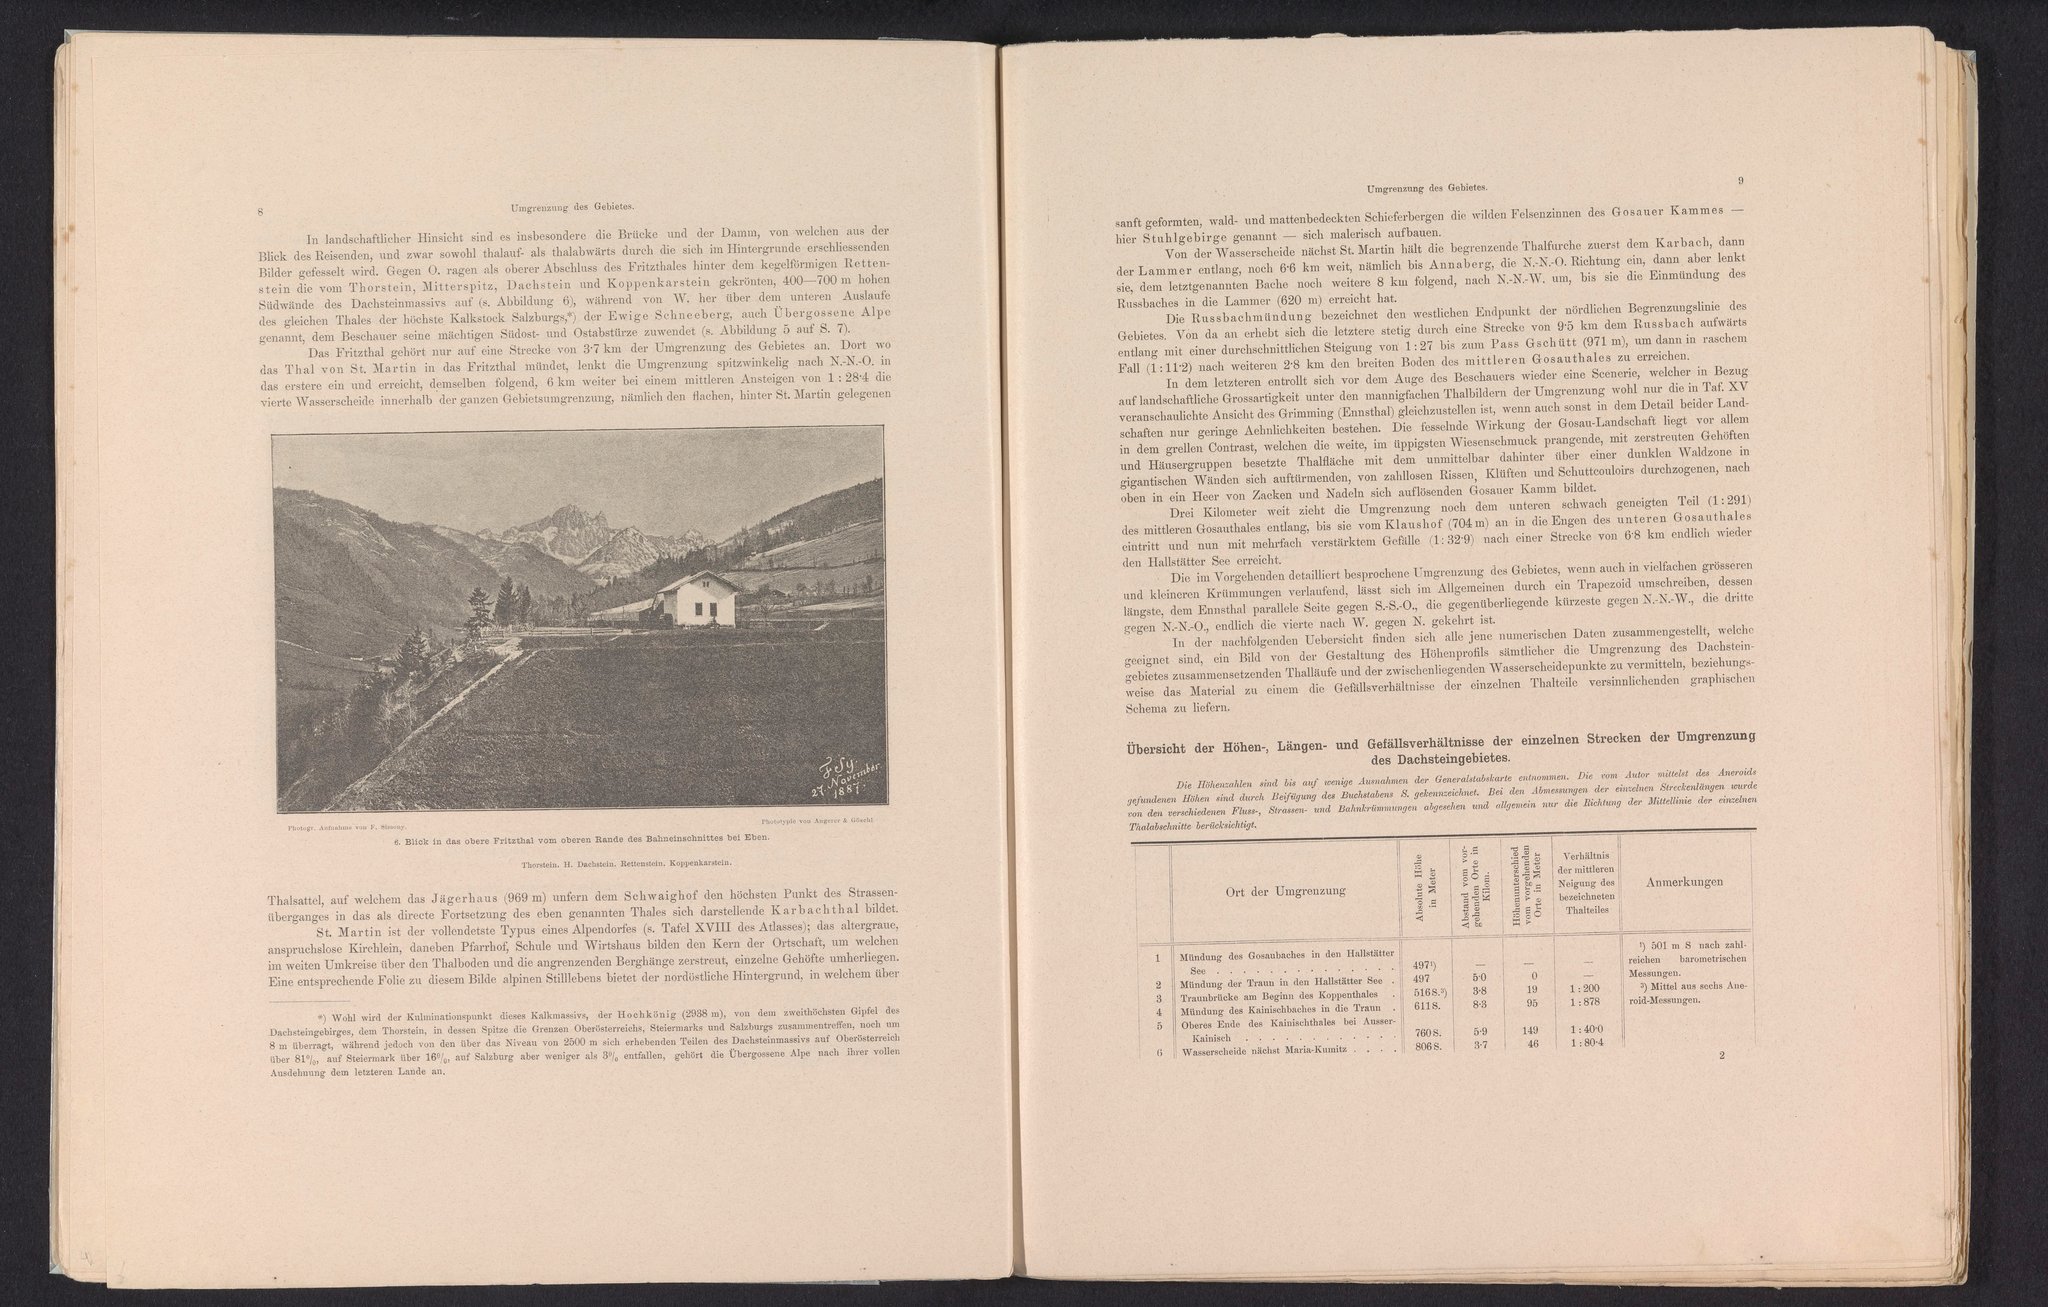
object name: page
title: Gezicht op een dal te Oostenrijk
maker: friedrich simony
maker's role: geograaf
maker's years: 1813-1896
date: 1887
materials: paper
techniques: autotype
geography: salzburg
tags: dale, valley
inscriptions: number: ‘6.’